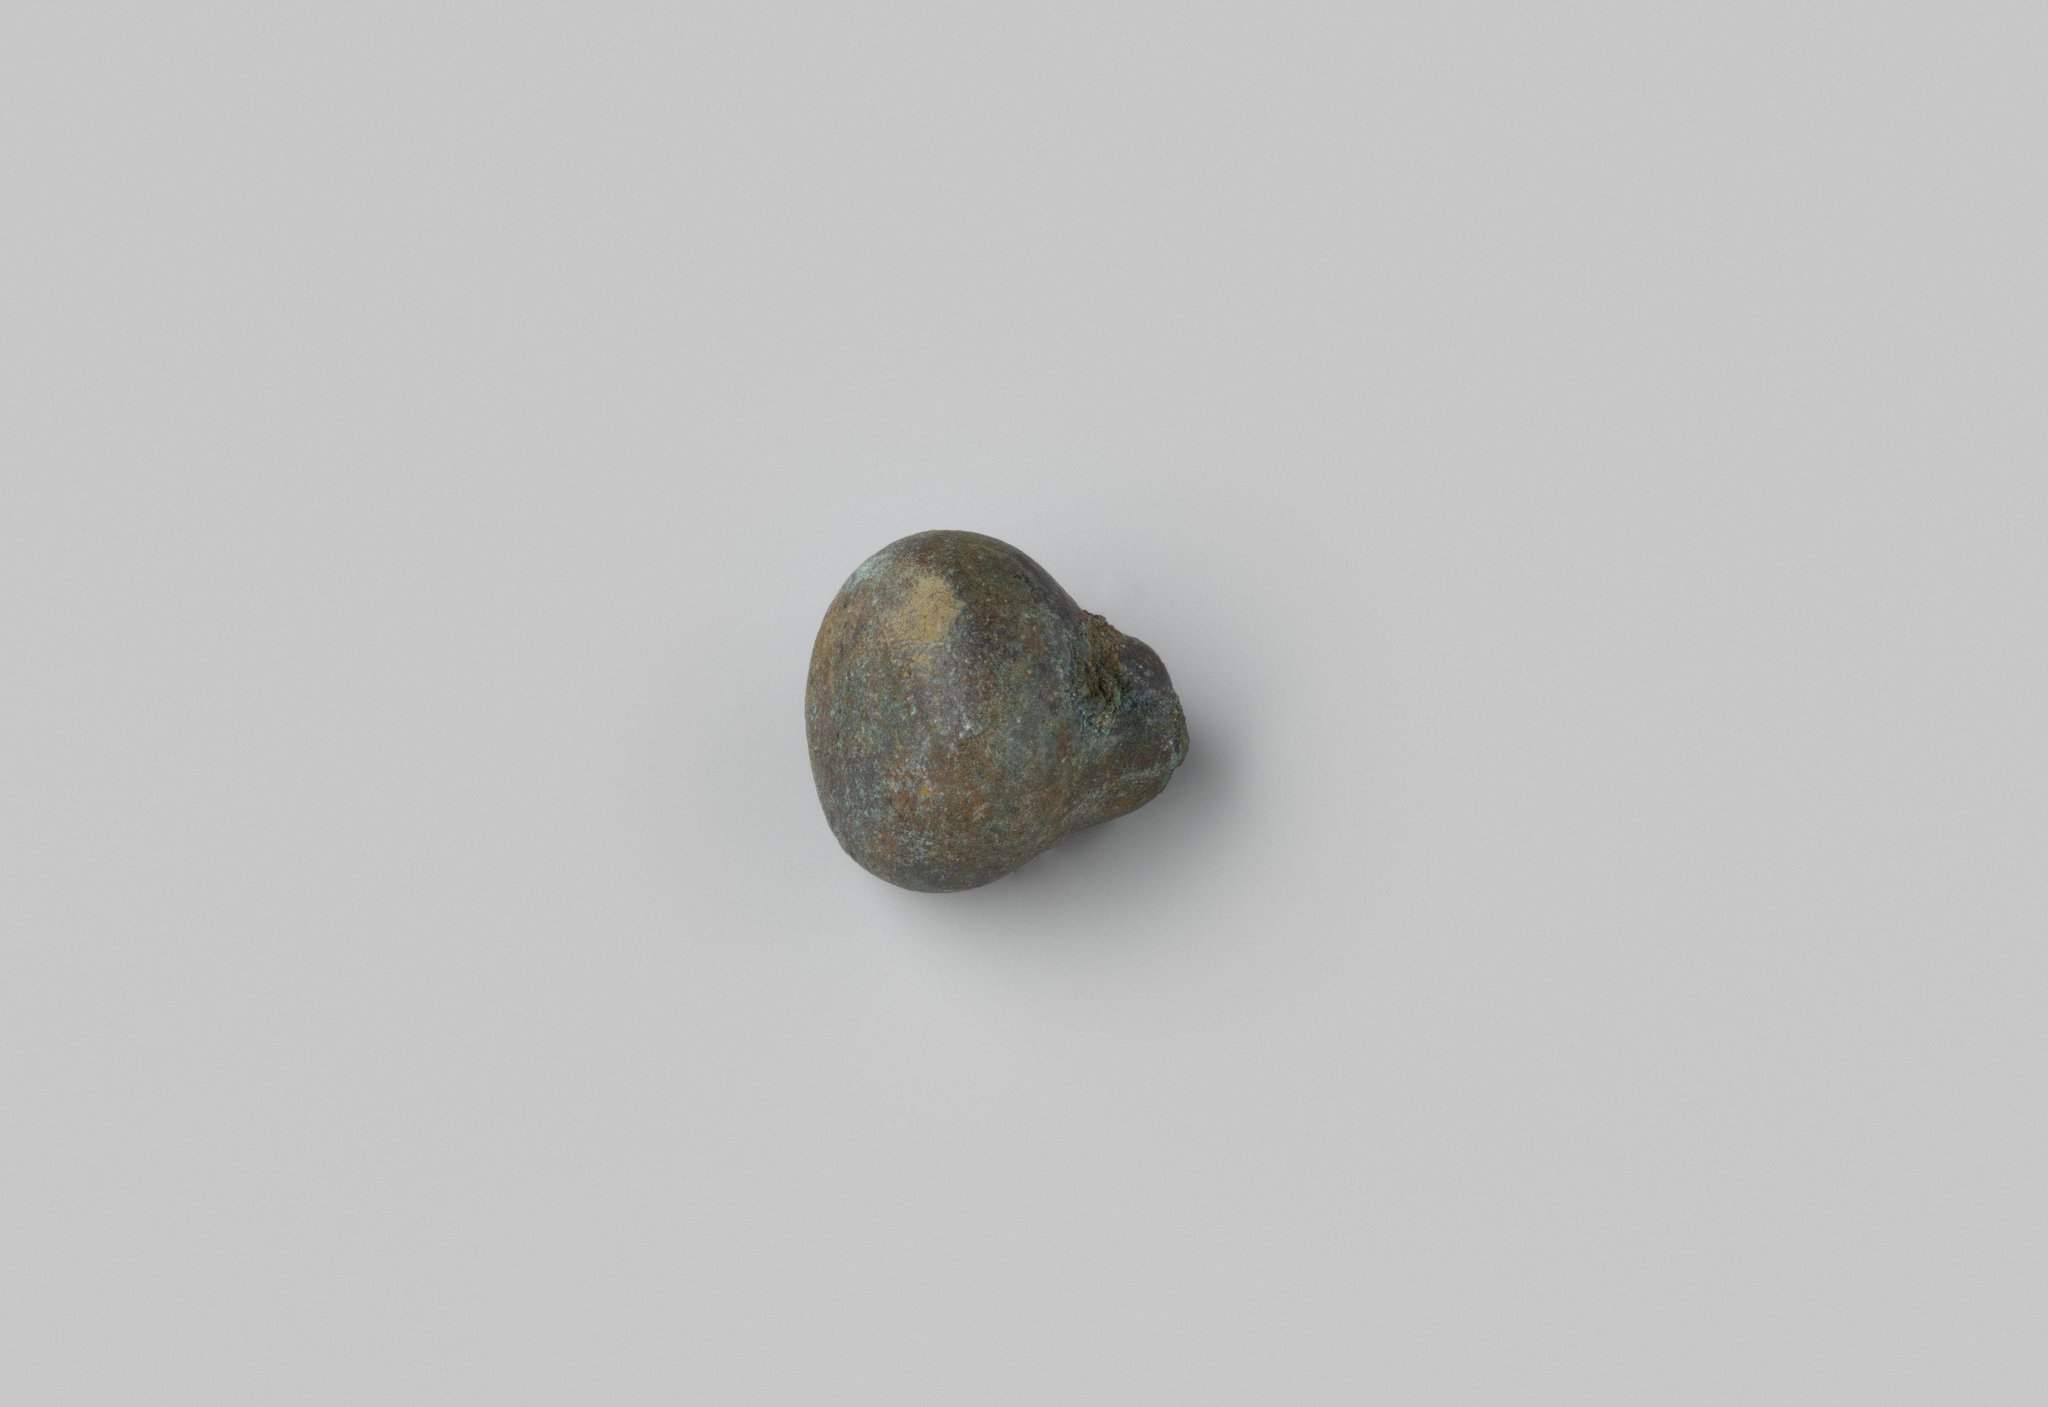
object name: knob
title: Knop uit het wrak van de Oost-Indiëvaarder Hollandia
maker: Anonymous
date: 1700-1743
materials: copper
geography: netherlands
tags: verenigde oostindische compagnie, hollandia (schip), annet